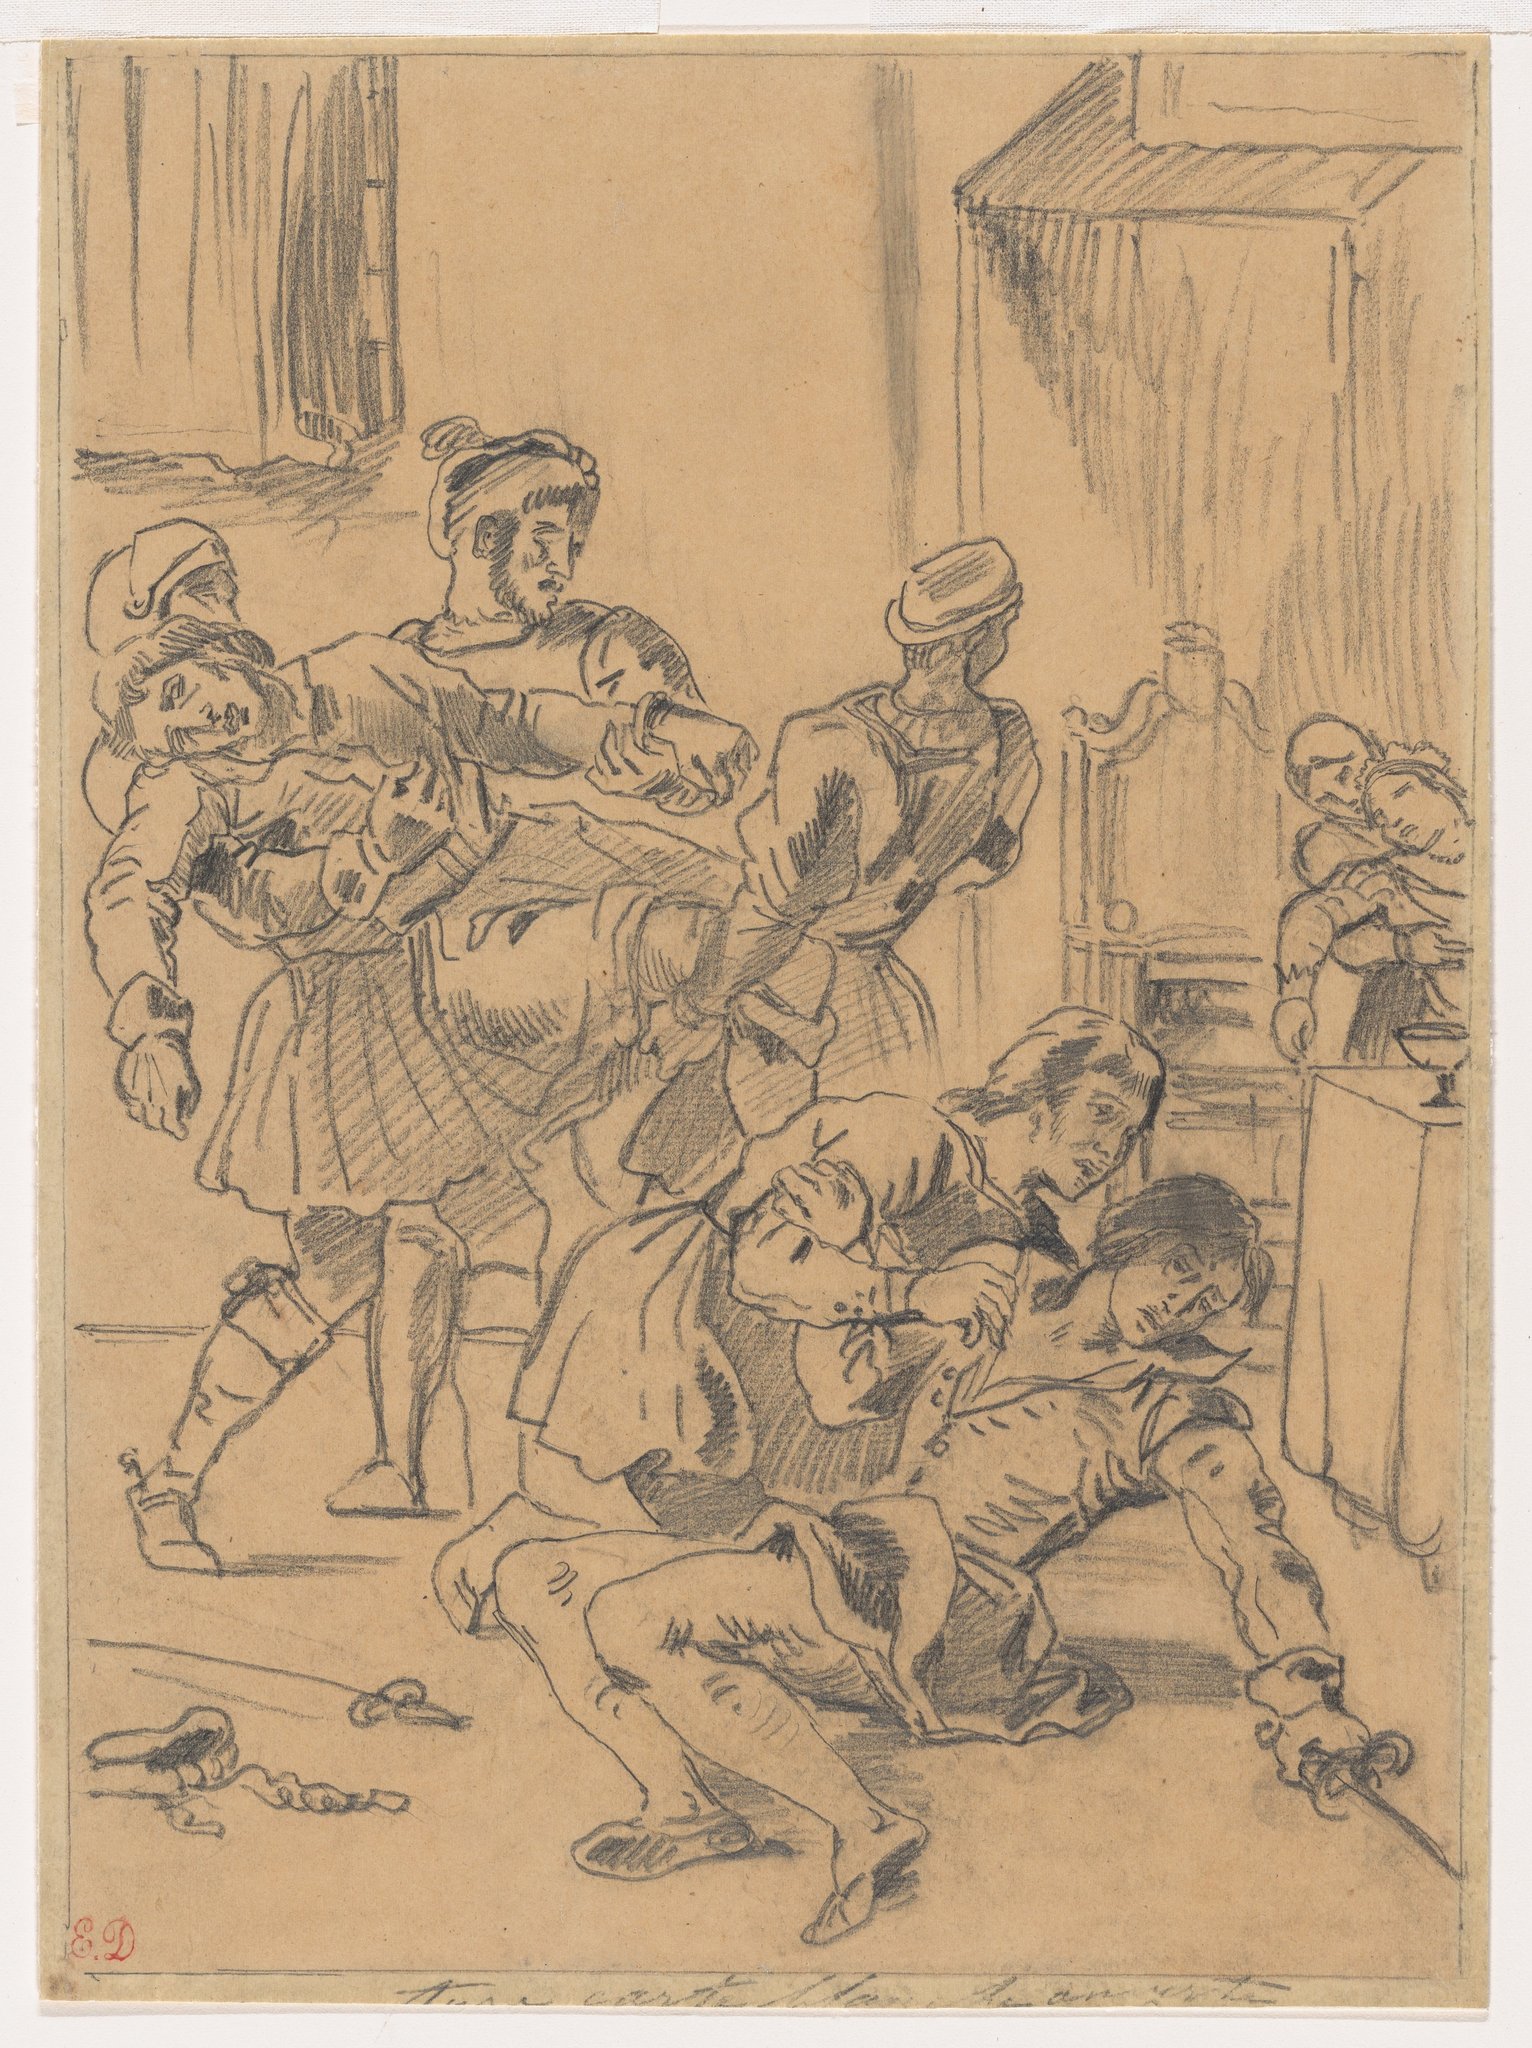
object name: drawing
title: The Death of Hamlet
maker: eugène delacroix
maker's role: artist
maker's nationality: french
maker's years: 1798-1863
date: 1843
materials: graphite